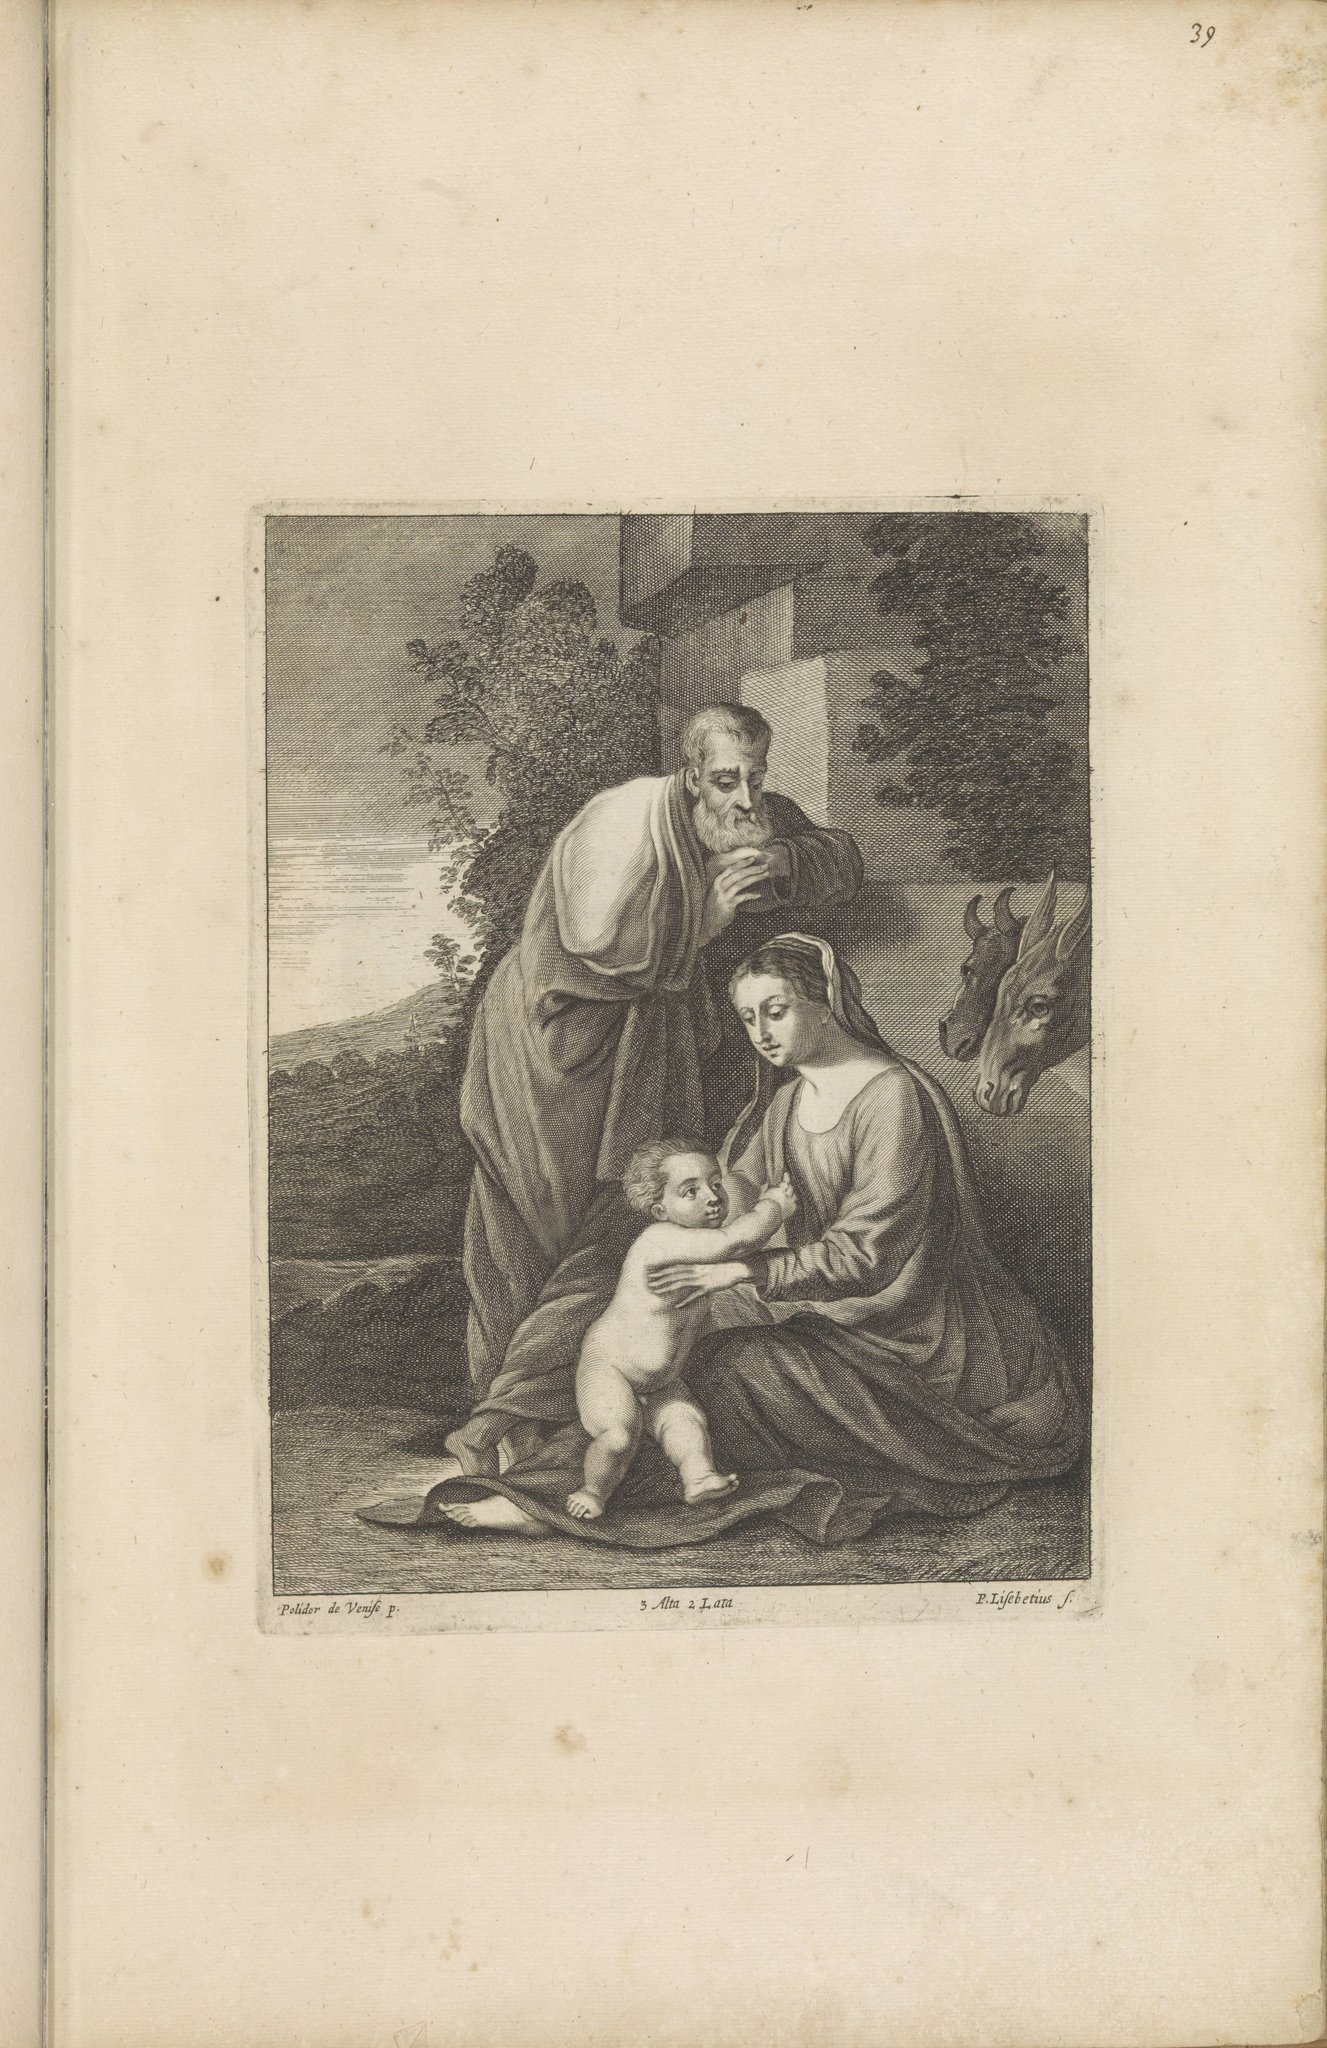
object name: album leaf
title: Heilige Familie in een landschap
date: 1660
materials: paper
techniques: engraving, etching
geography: venice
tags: ass, donkey, landscapes in the temperate zone, holy family (alone), 'trinitas terrestris', ox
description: David Teniers heeft waarschijnlijk van alle schilderijen uit de collectie van Leopold Willem van Oostenrijk een olieverfstudie op doek of paneel vervaardigd (zgn. pasticcio), die als voorbeeld voor de prentmakers diende. Het is niet altijd duidelijk of de pasticci door hem zijn gemaakt of door zijn atelier. Niet alle pasticci zijn overgeleverd.